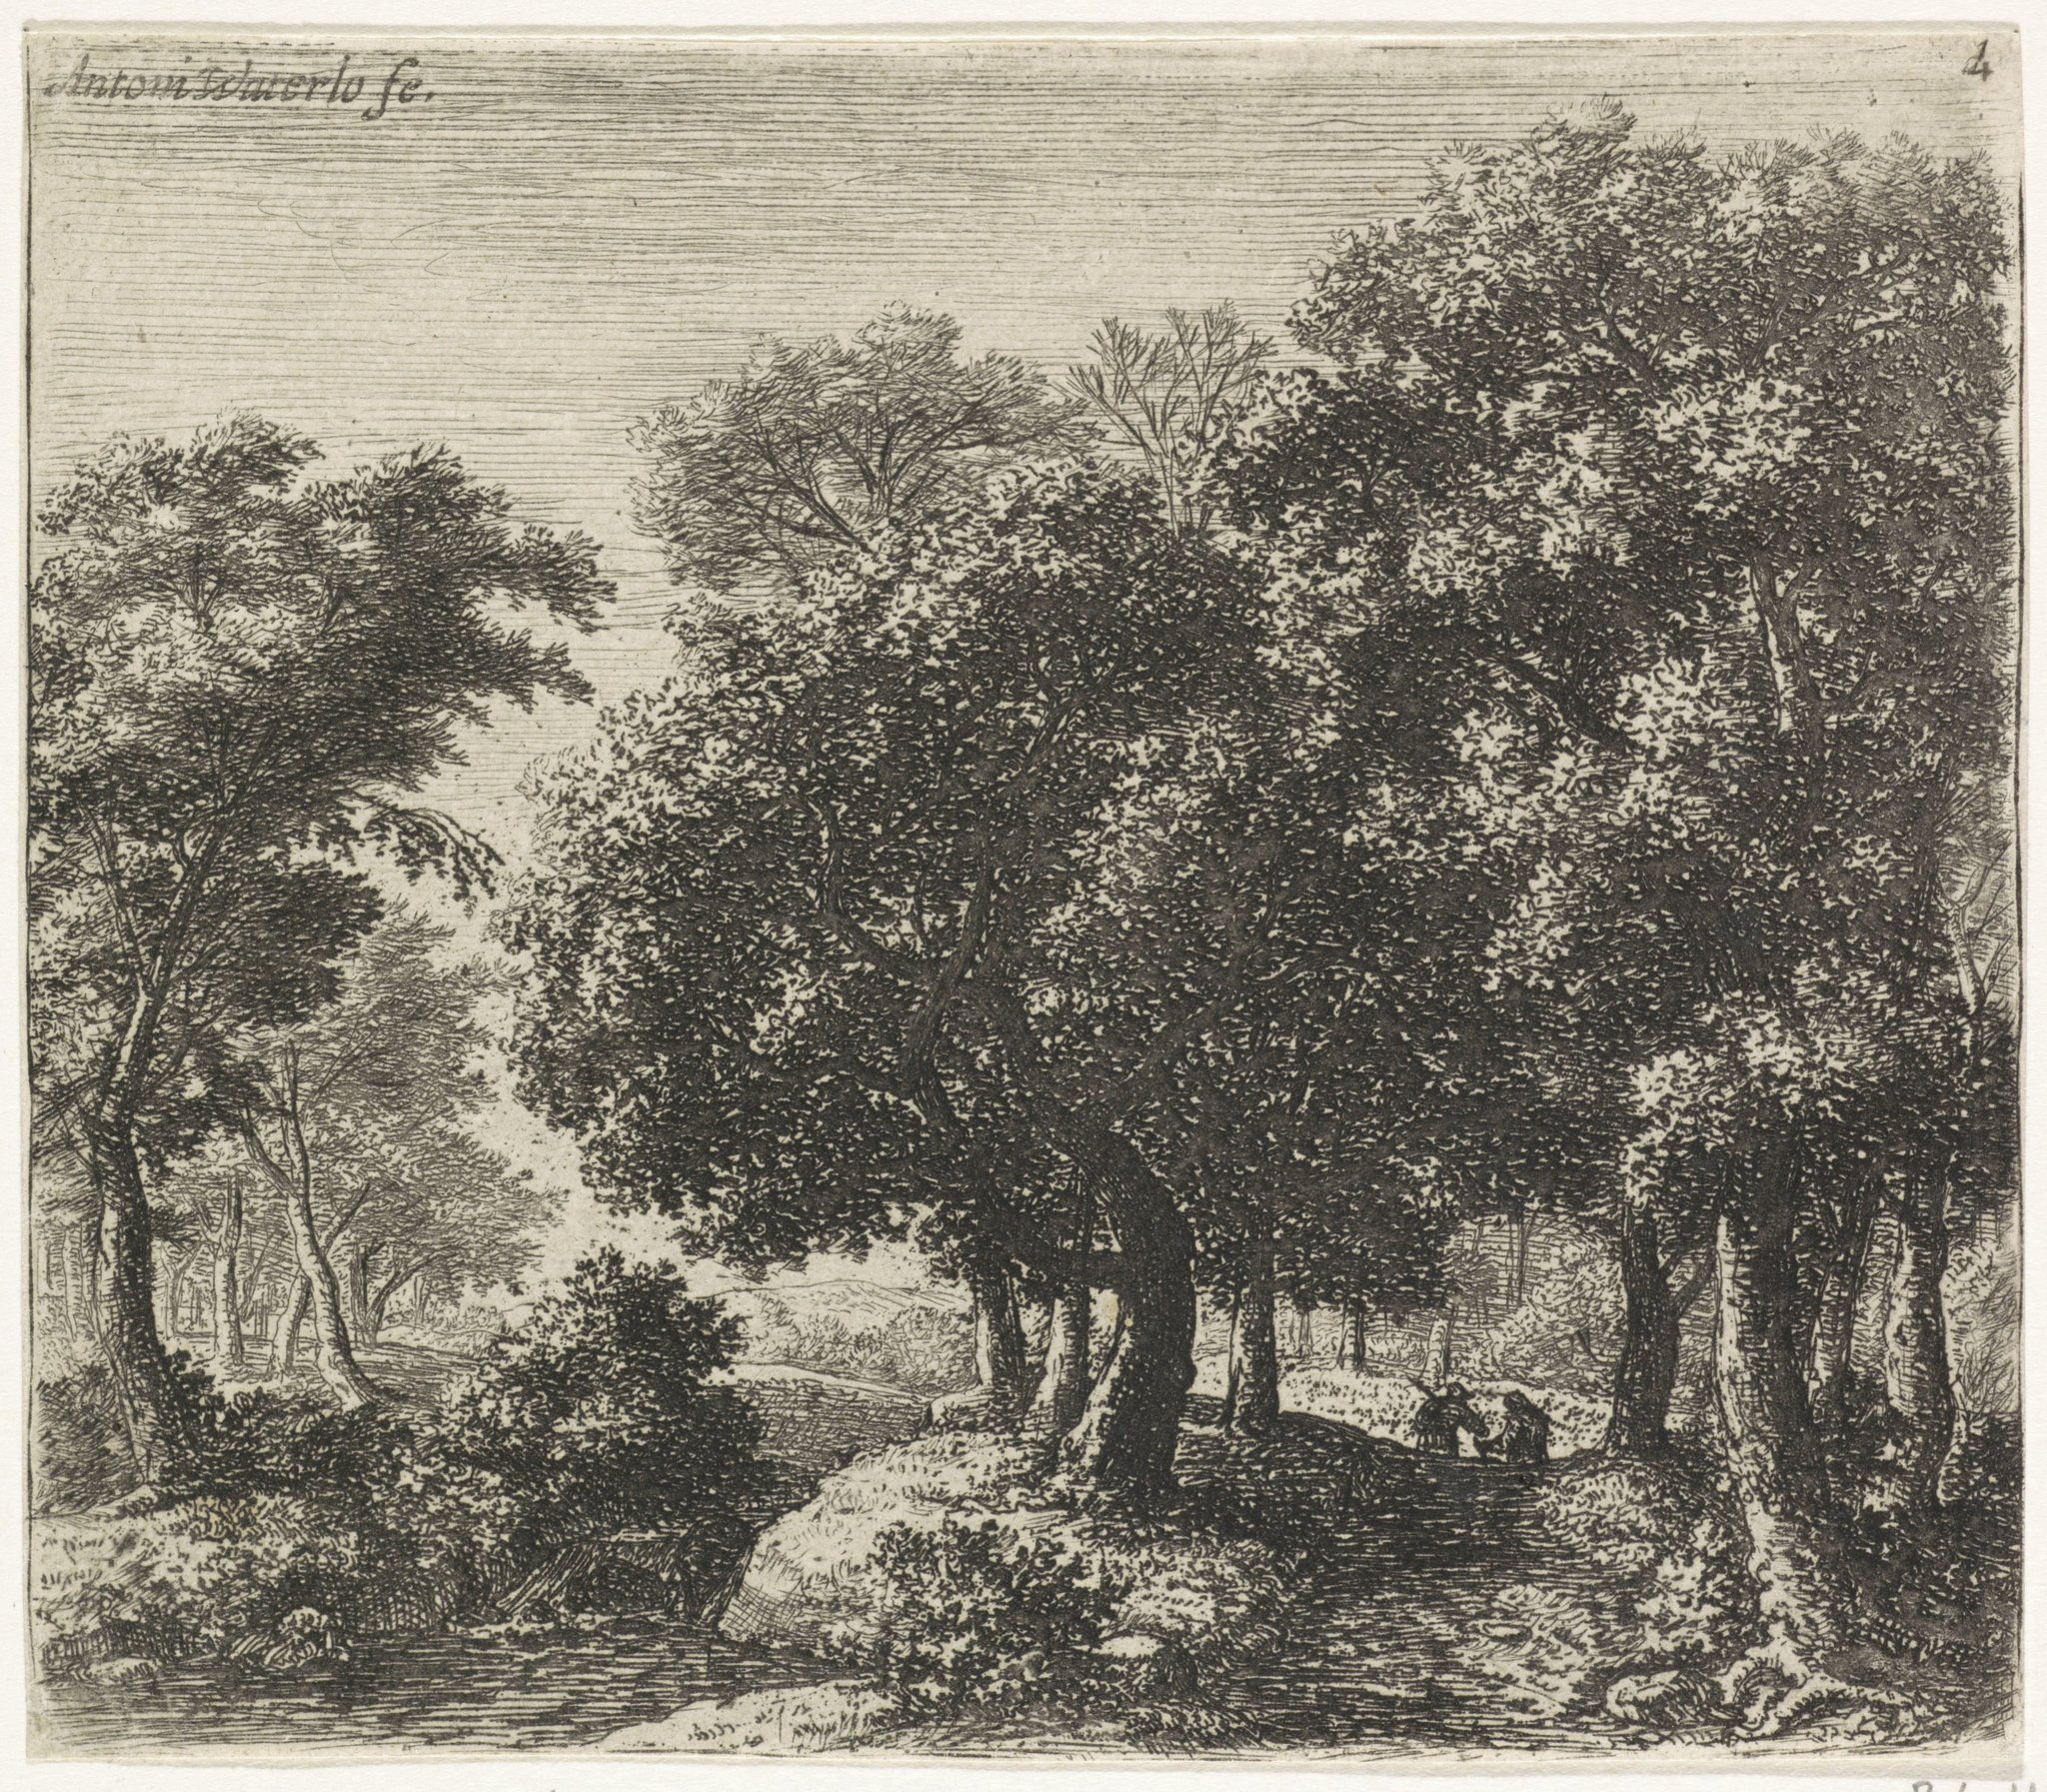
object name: print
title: Twee figuren op een bospad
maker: anthonie waterloo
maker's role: draughtsman, painter, print maker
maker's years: 1609-1690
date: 1630-1663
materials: ink, paper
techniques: etching, pen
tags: brook, forest path or lane, landscapes (+ landscape with figures, staffage)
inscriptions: collector's mark: Lugt 2228, inscription: ‘...au Louvre 1770’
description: Zie Hollstein voor een volledig overzicht van de verschillende edities.